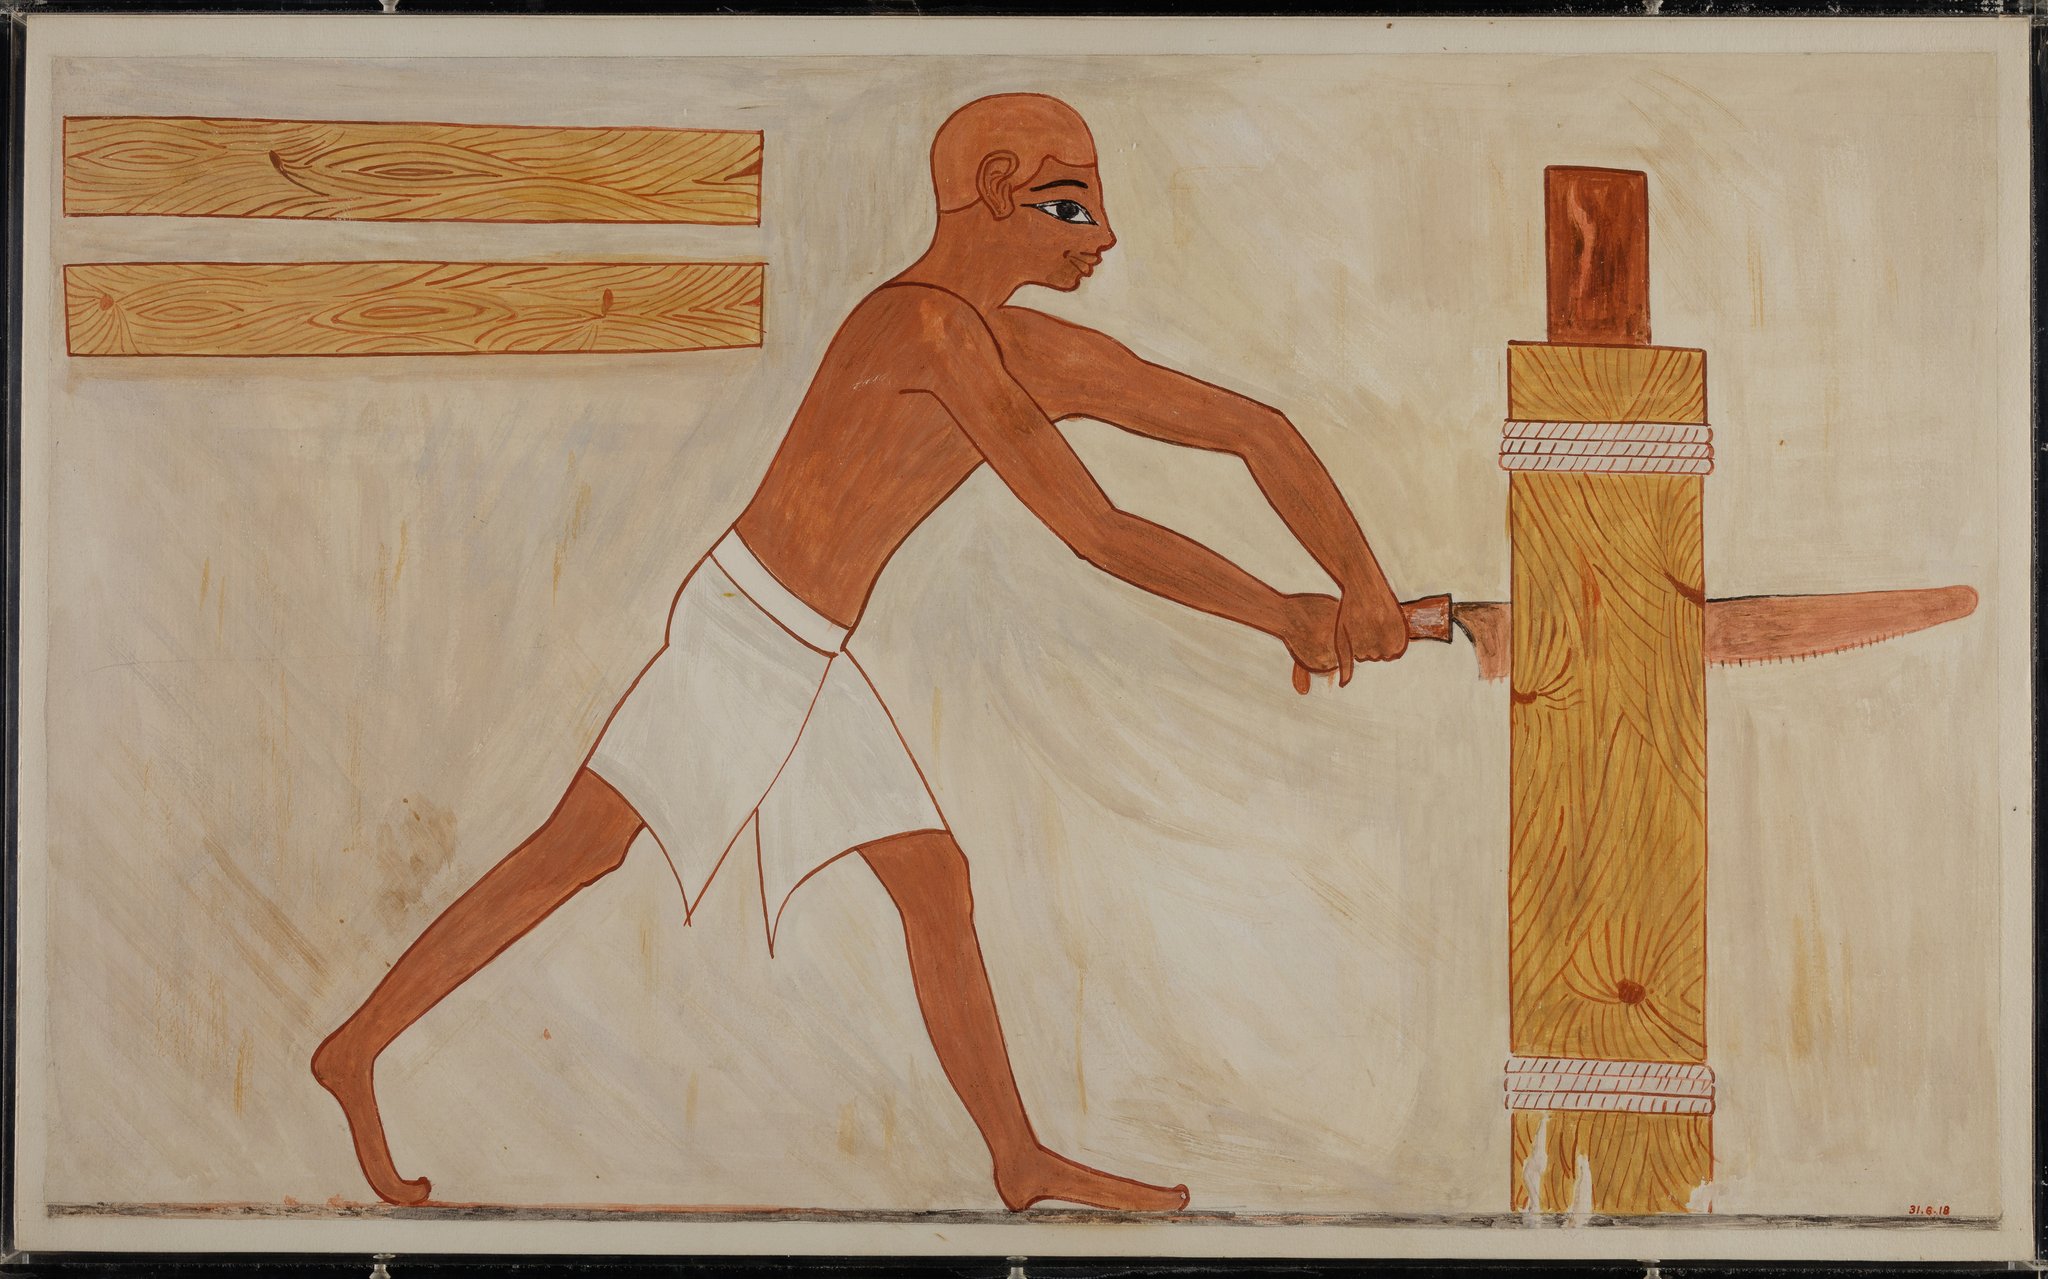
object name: facsimile, rekhmire tt 100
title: Sawing a Plank, Tomb of Rekhmire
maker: nina de garis davies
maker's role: artist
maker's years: 1881-1965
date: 1504-1425 BCE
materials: ink, paint, paper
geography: egypt